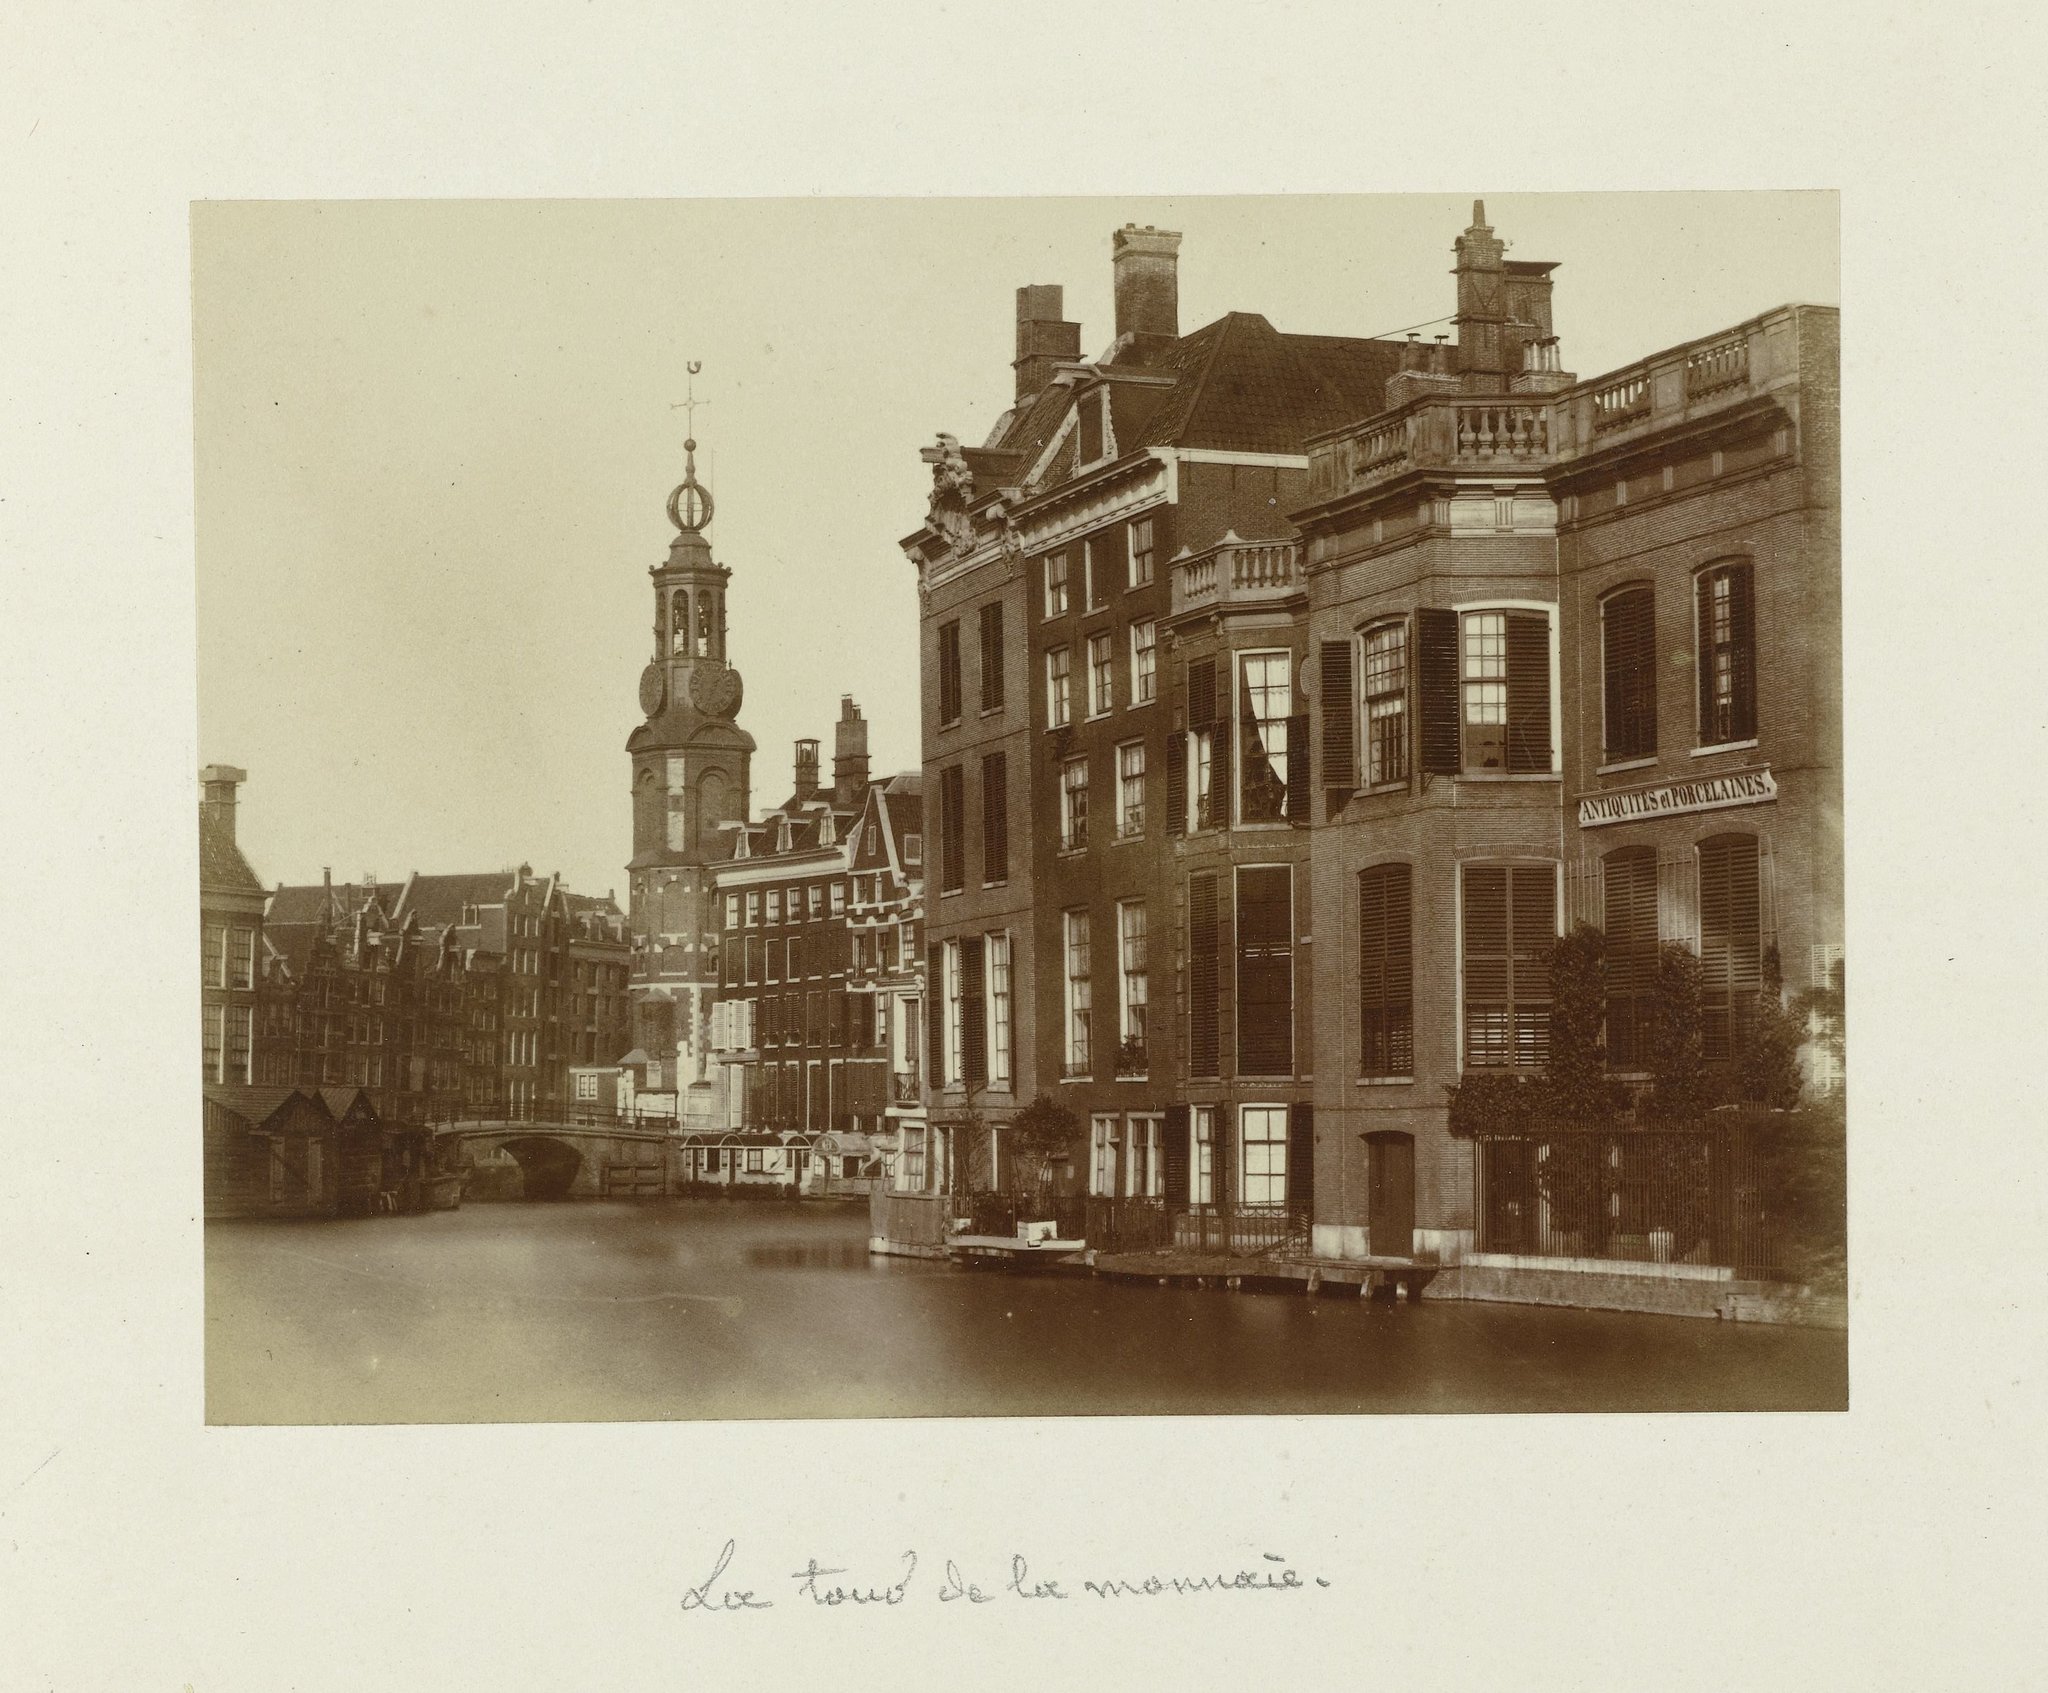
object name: page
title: Munttoren, Amsterdam, gezien vanaf de Amstel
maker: pieter oosterhuis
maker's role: draughtsman, print maker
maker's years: 1816-1885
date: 1855-1860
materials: paper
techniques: albumen print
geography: amsterdam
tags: city-view in general; 'veduta'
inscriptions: inscription: ‘La tour de la monnaie’